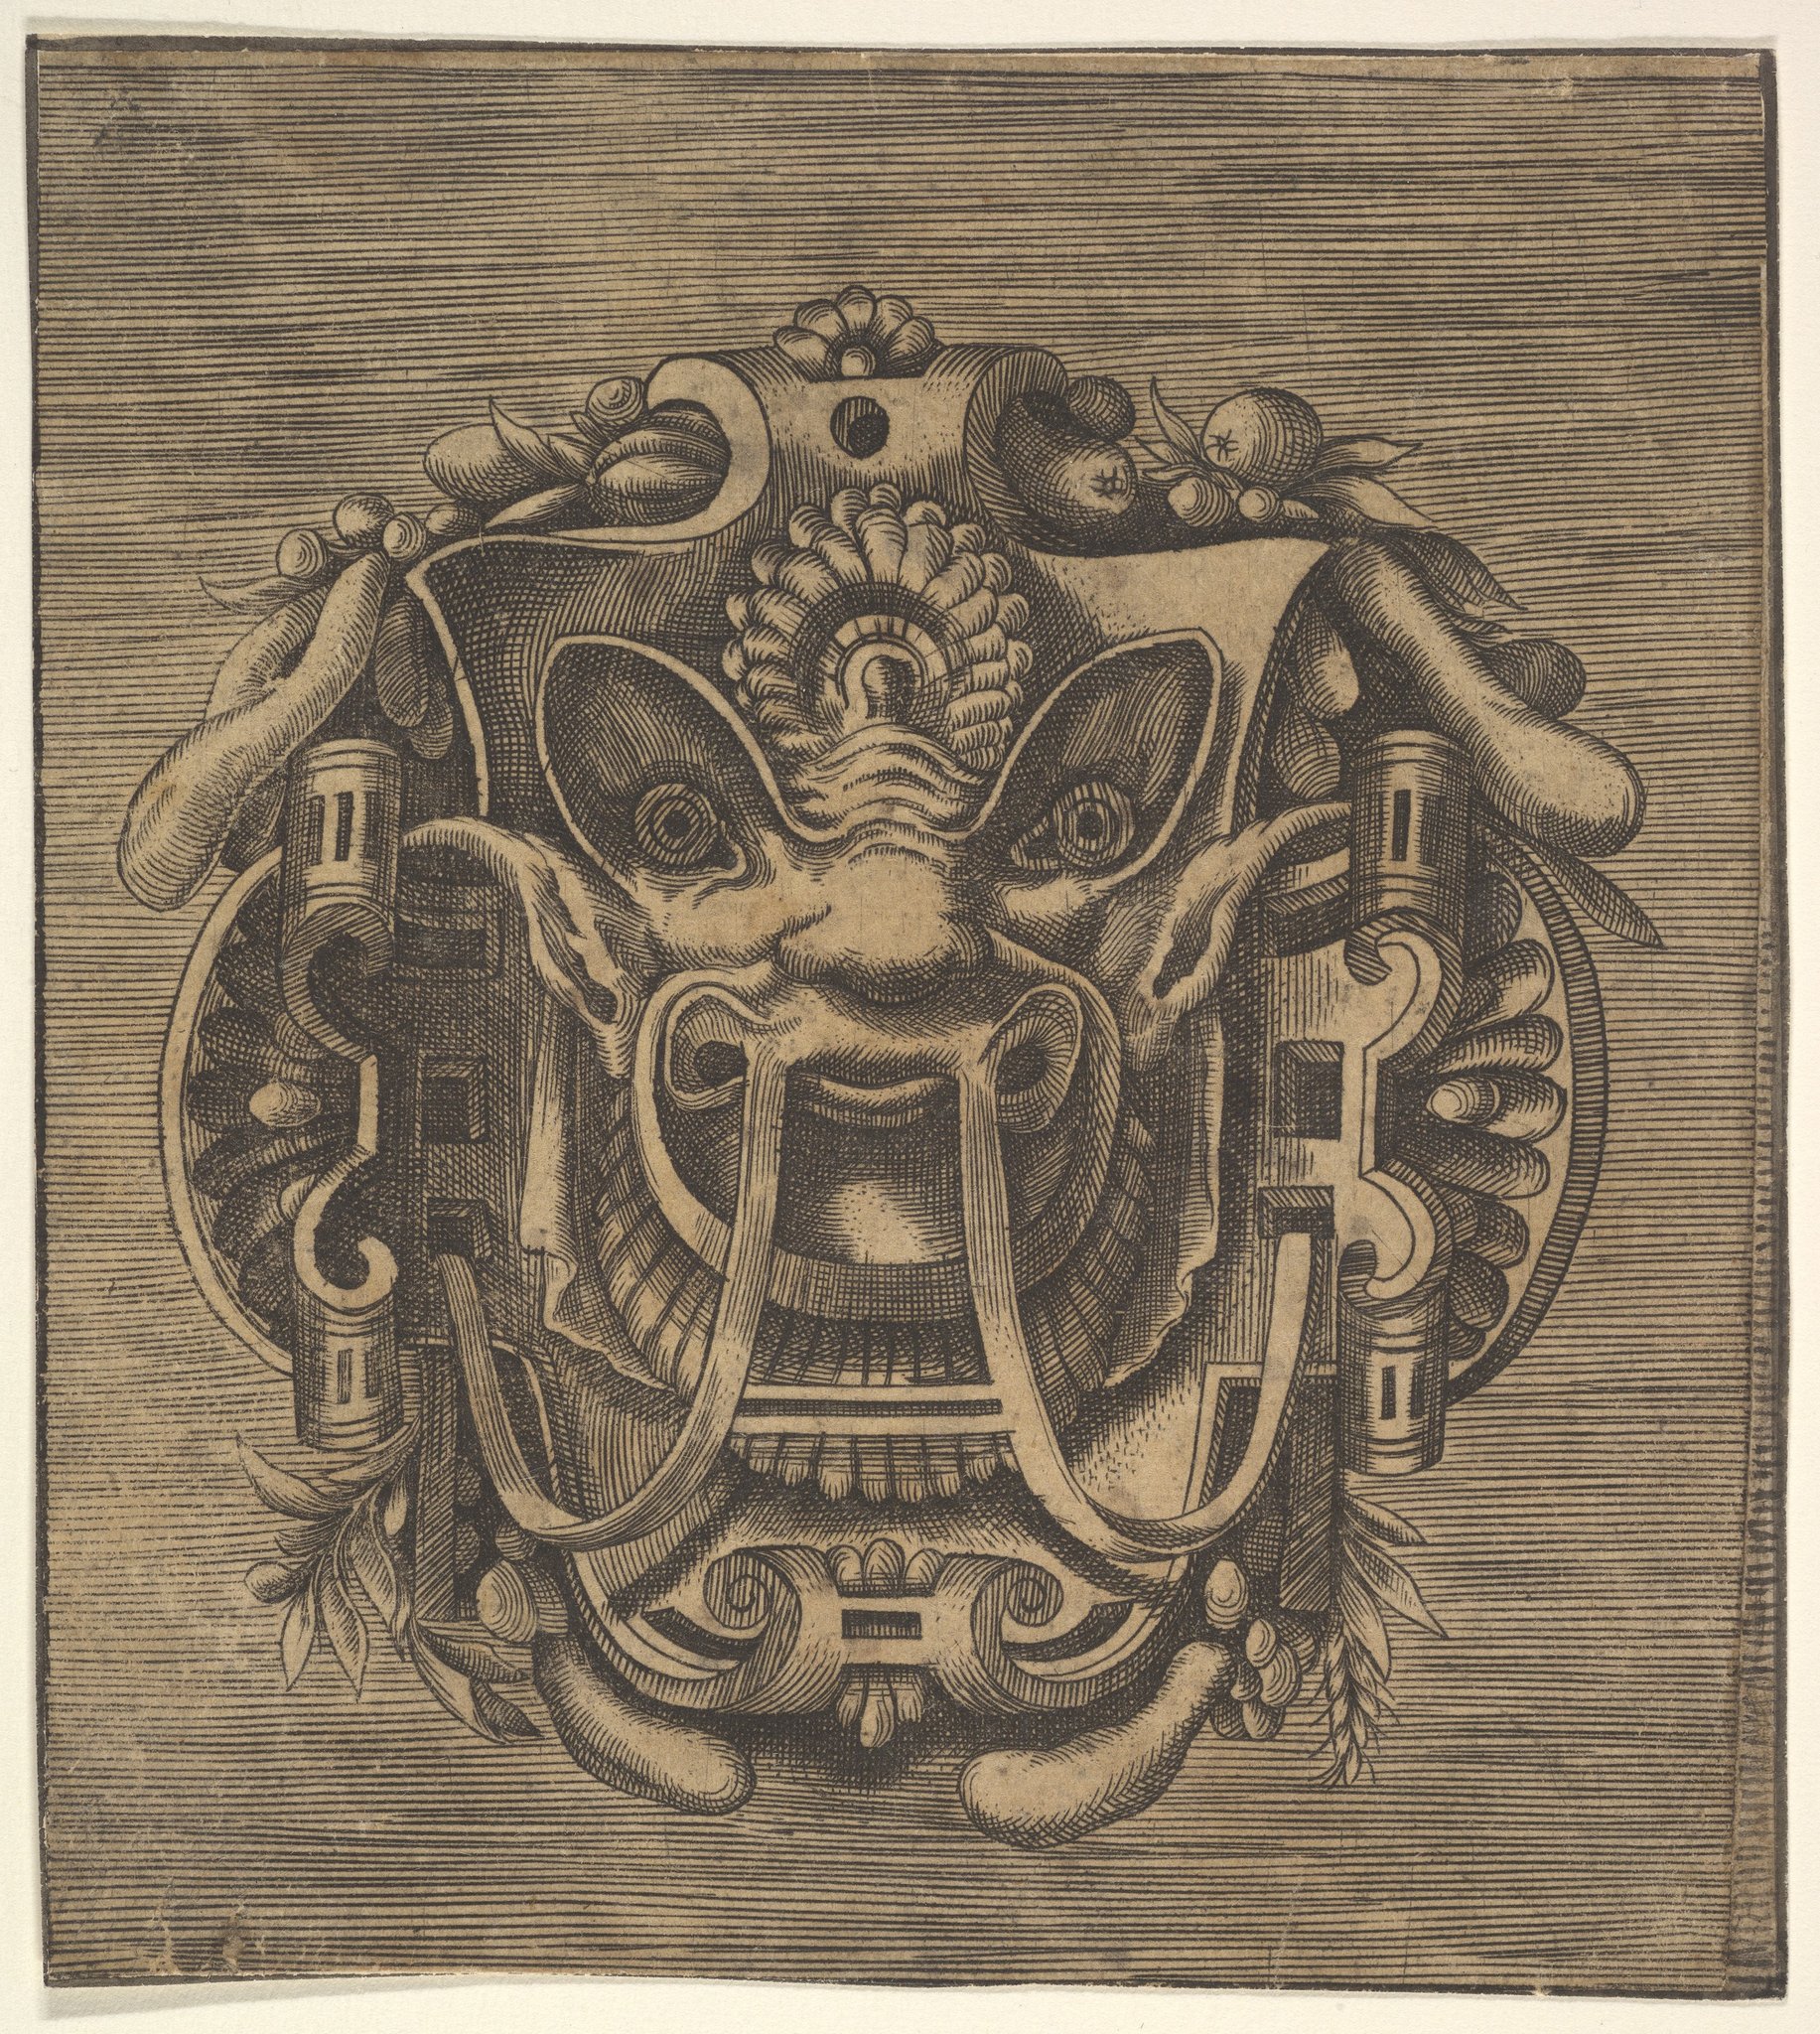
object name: print ornament architecture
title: Fantastical Mask with Strapwork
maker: anonymous, french, 16th century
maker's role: artist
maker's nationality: french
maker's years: 1500-1600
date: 1534-1566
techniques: engraving, etching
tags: masks